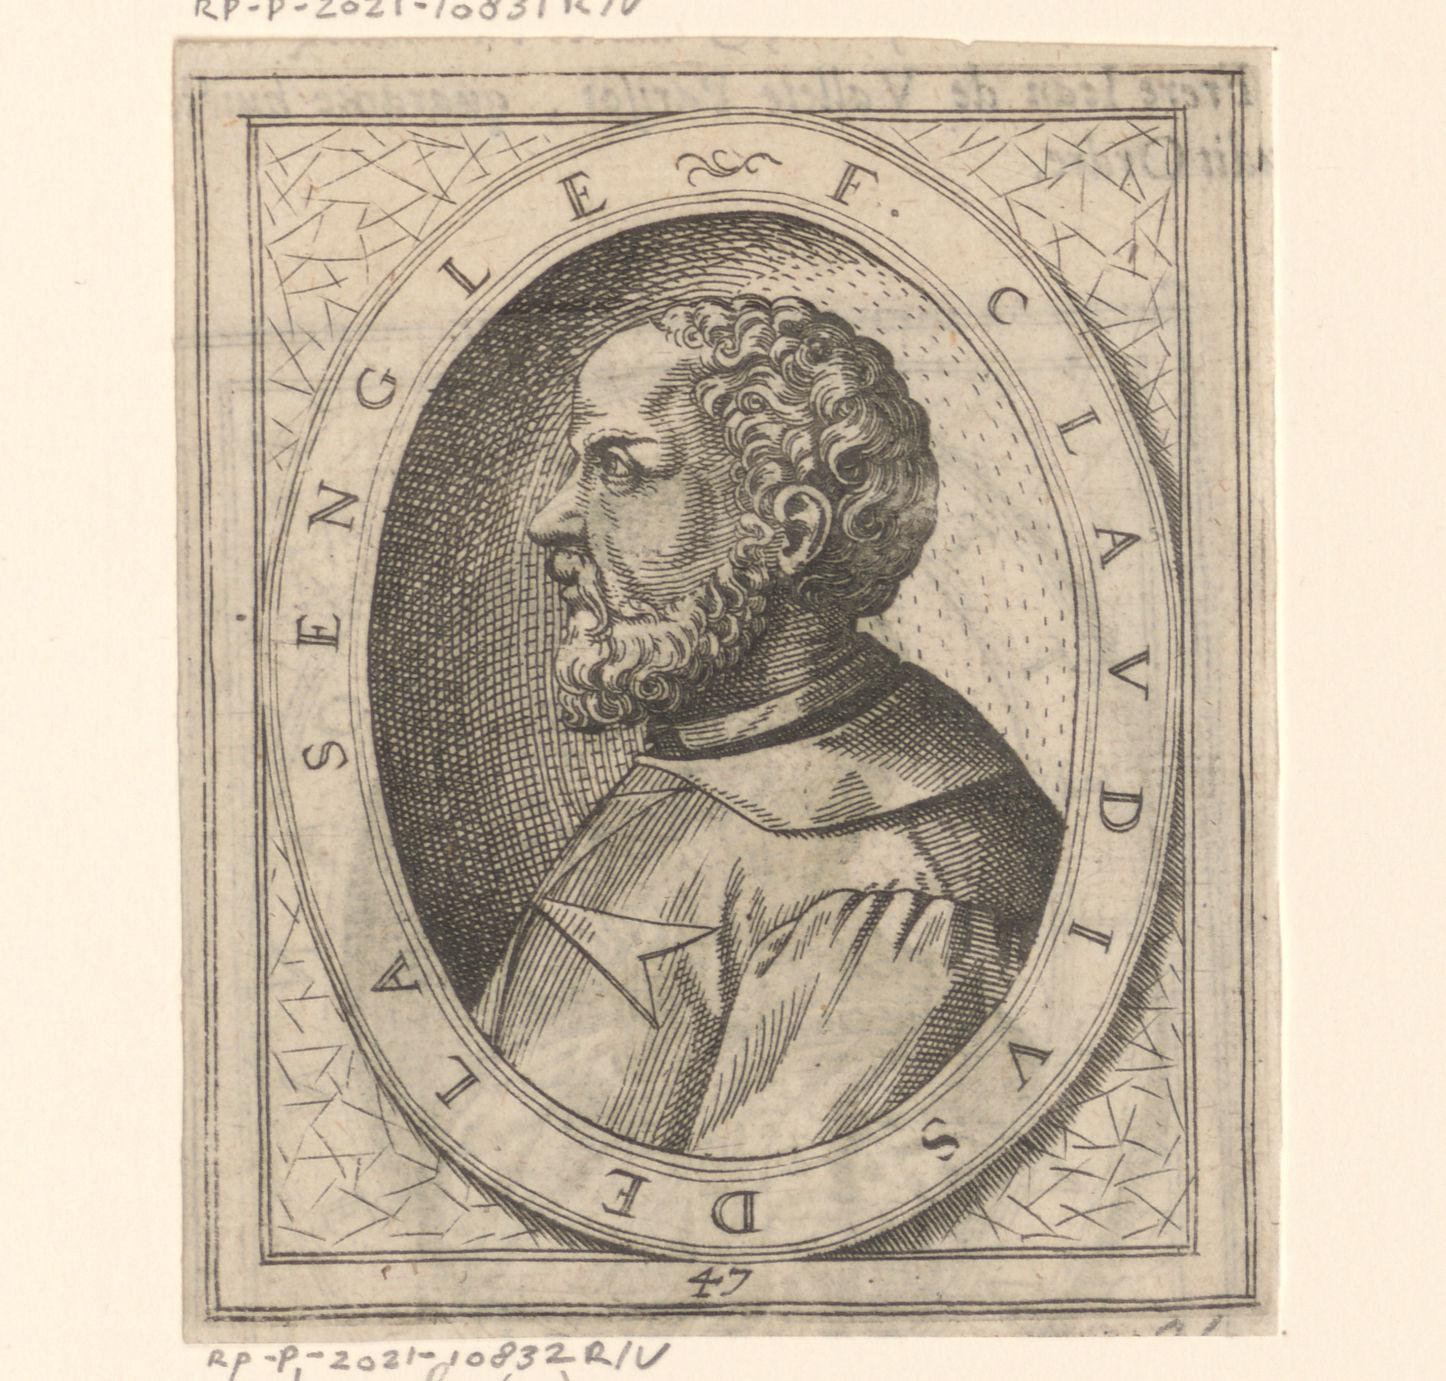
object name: print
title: Portret van Claude de la Sengle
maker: Anonymous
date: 1643-1659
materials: paper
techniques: engraving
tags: historical persons, military orders, e.g.: knights templars, knights of malta, teutonic knights ~ roman catholic church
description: Prent mogelijk uit: Baudoin, Jean. Histoire des chevaliers de l'ordre de s. Jean de Hierusalem (...). Parijs: Jacques Dallin, 1643. Of uit: Baudoin, Jean. Histoire des chevaliers de l'ordre de s. Jean de Hierusalem (...). Parijs: Thomas Jolly, 1659.